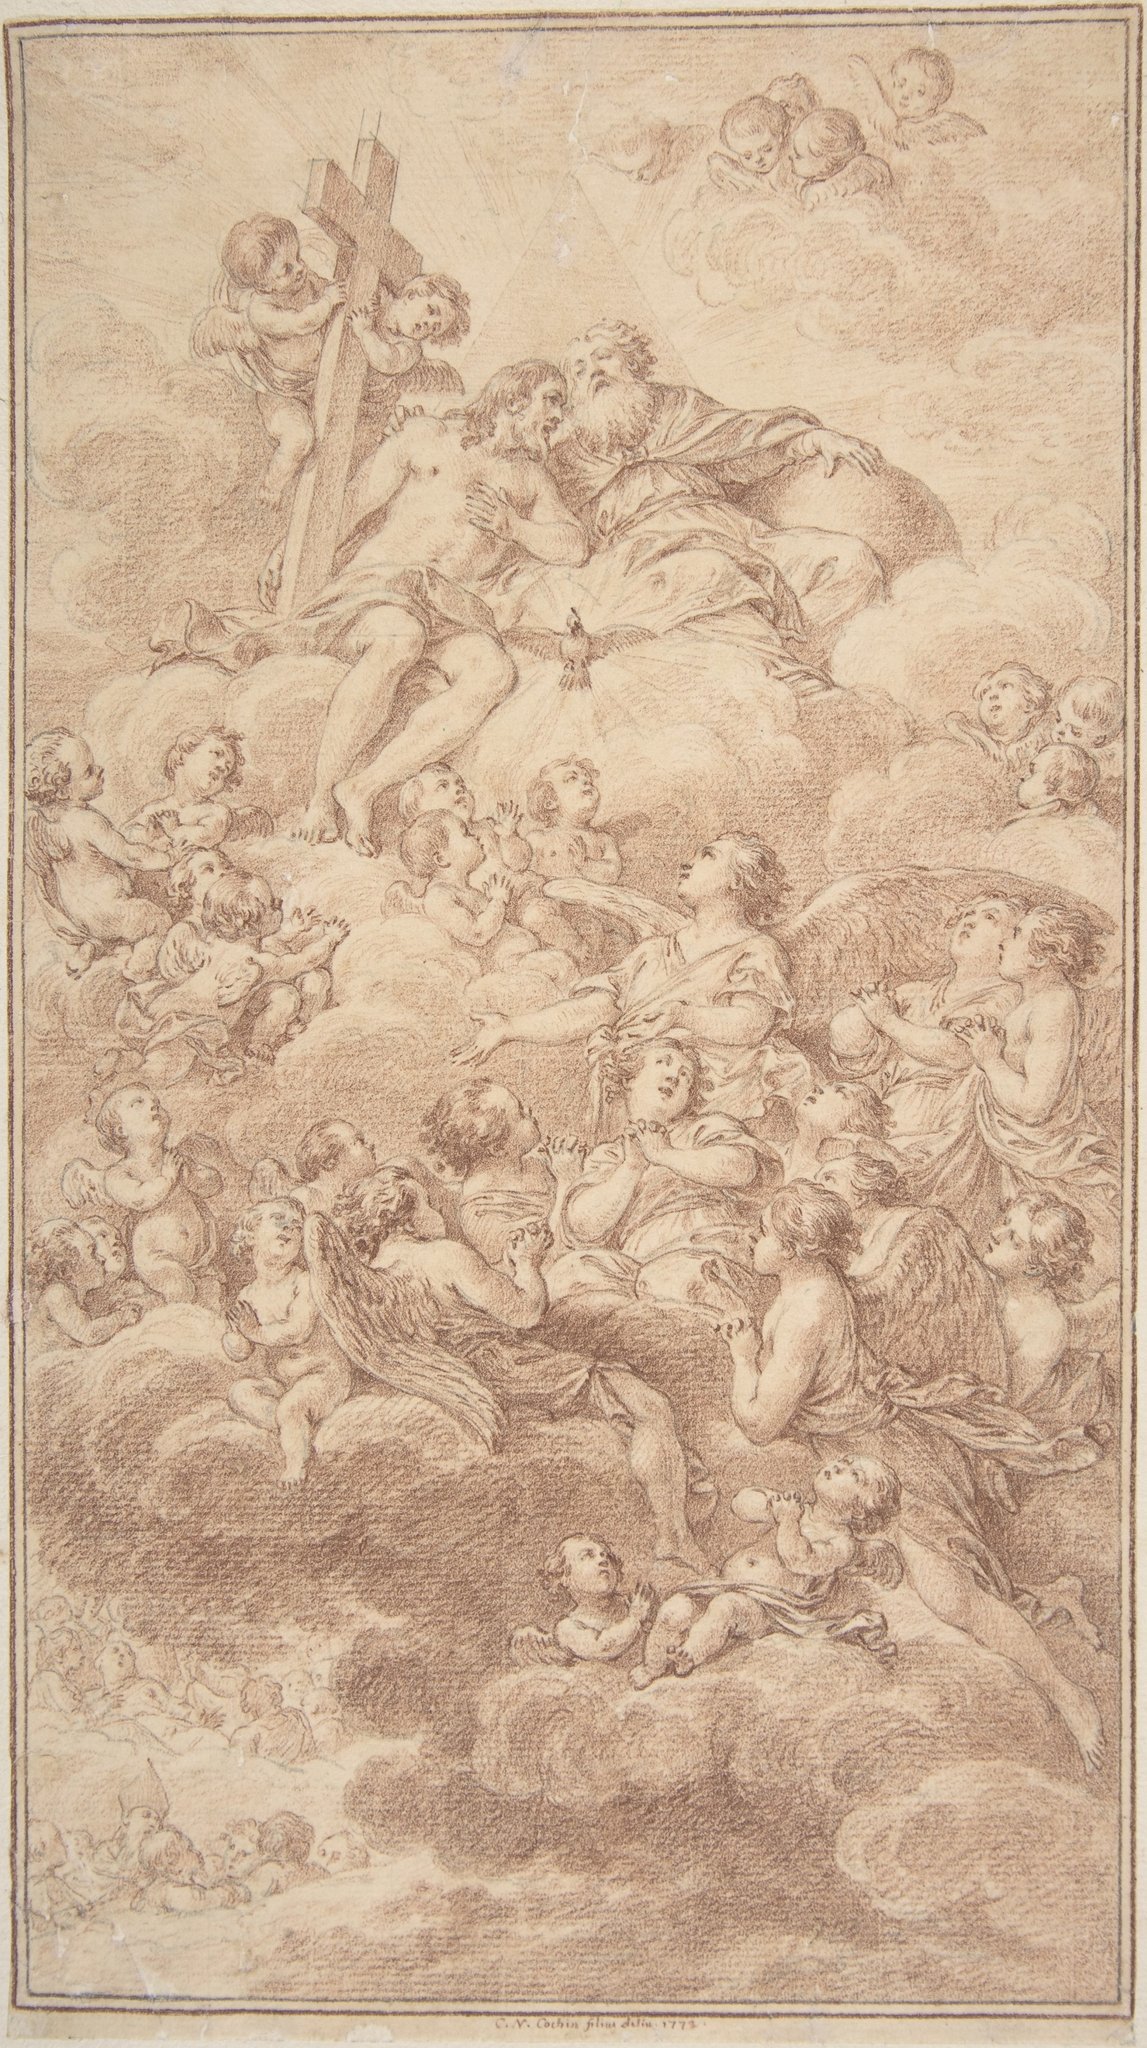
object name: drawing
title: Angels Adoring the The Holy Trinity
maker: charles nicolas cochin ii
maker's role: artist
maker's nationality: french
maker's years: 1715-1790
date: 1772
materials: chalk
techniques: drawing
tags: angels,jesus,god the father